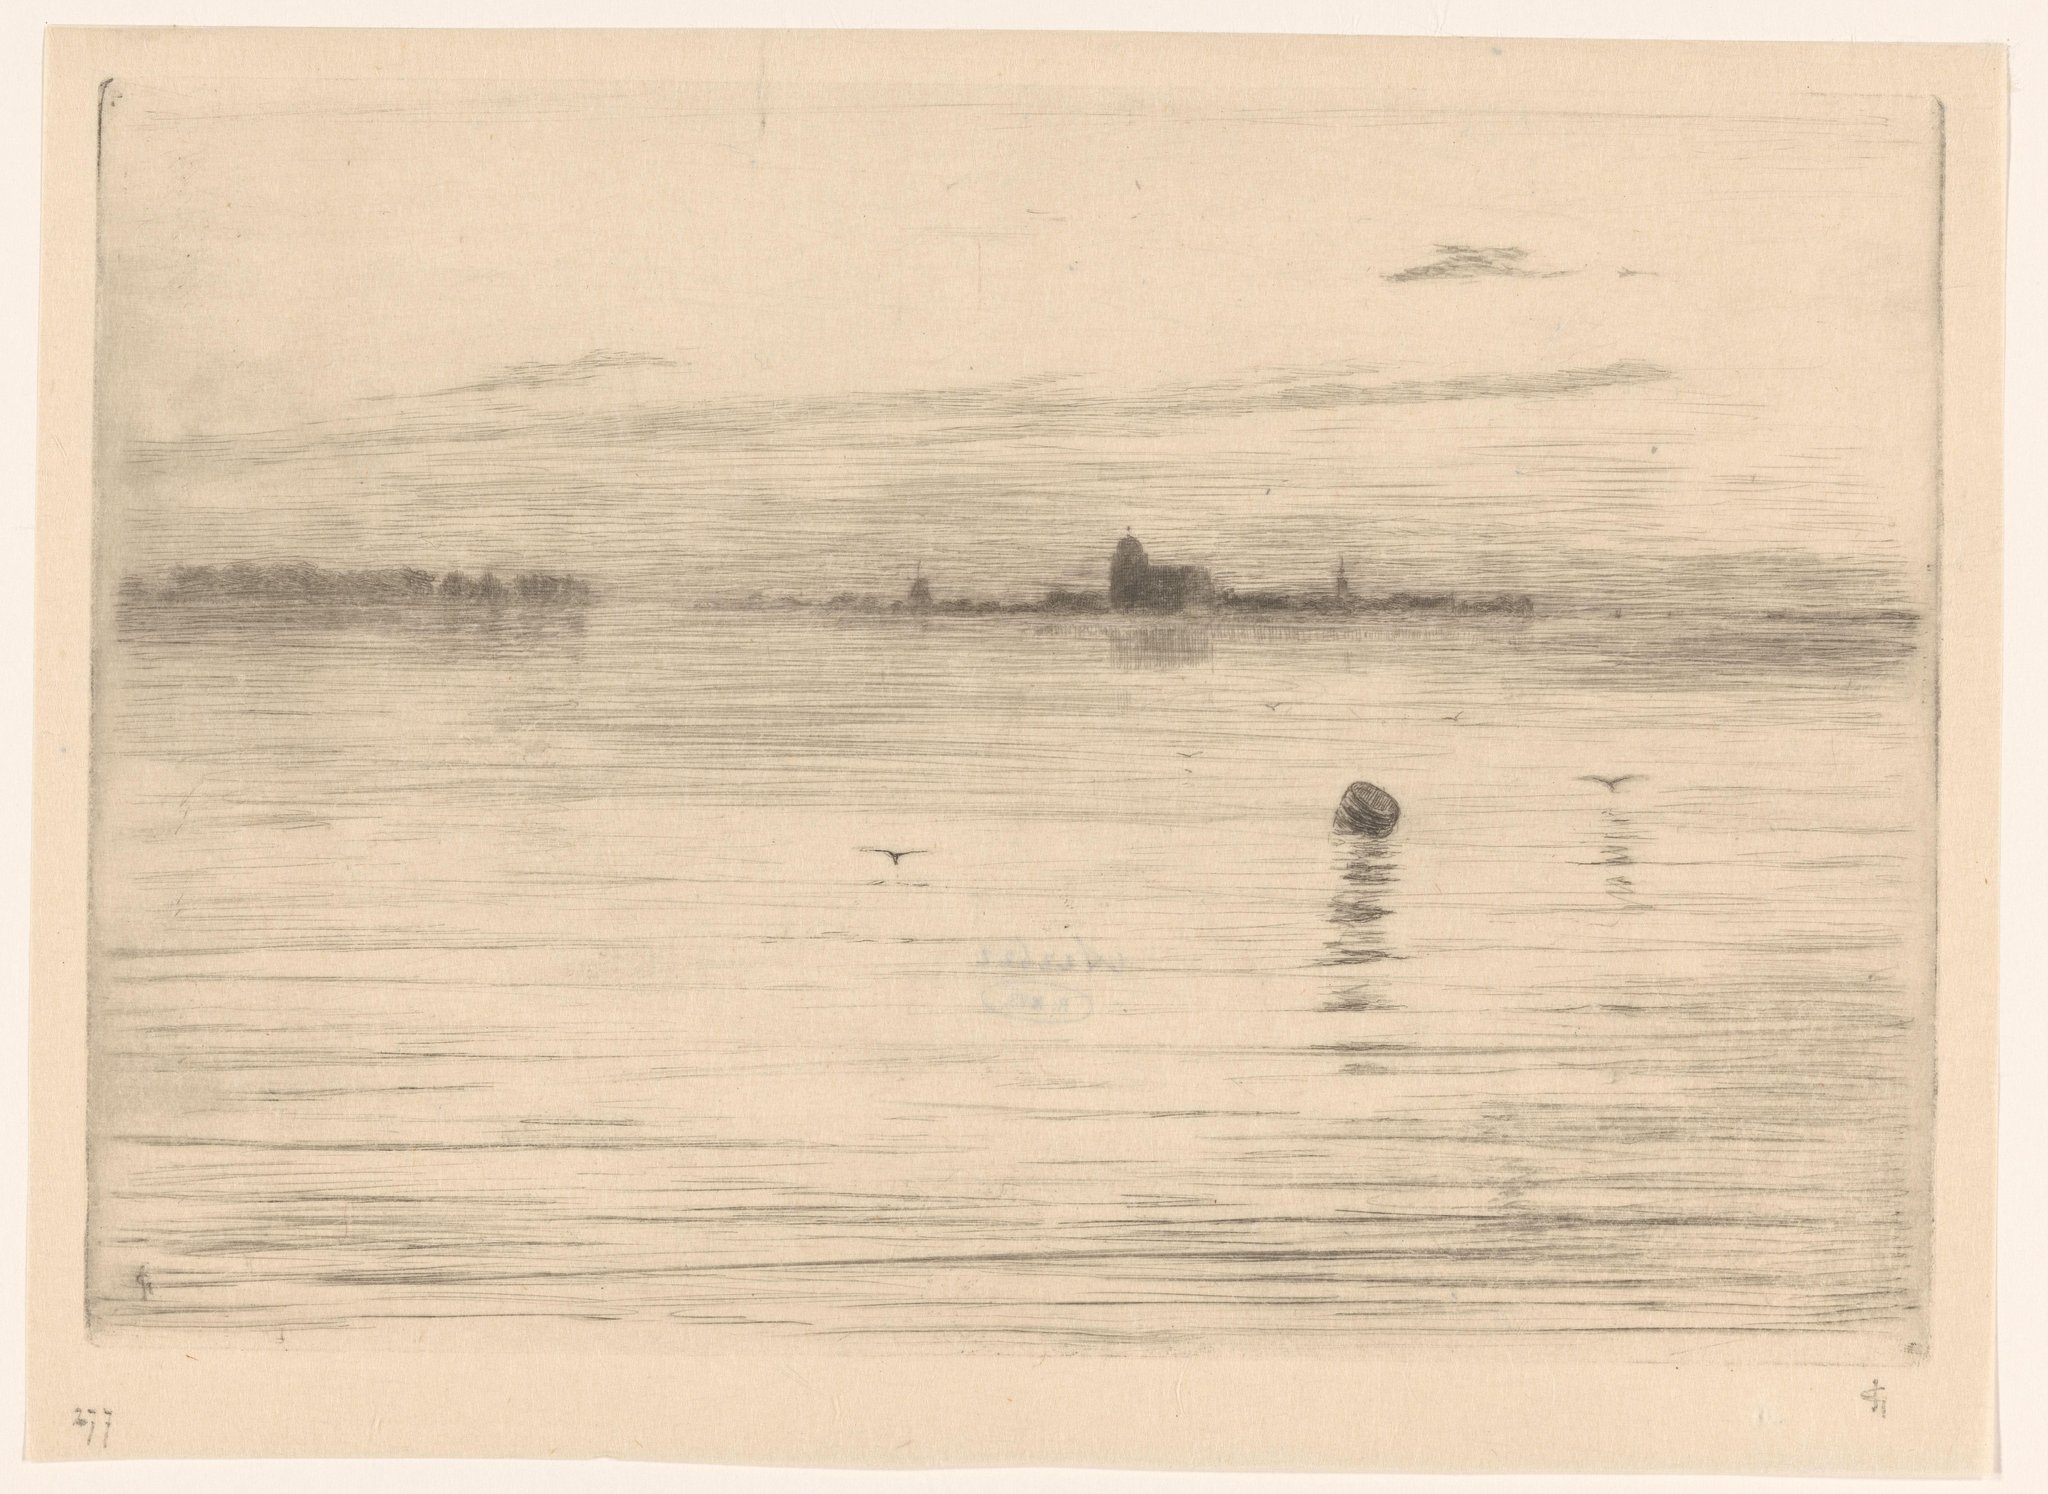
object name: print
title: Gezicht op de Schelde bij Veere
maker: carel nicolaas storm van s-gravesande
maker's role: draughtsman, print maker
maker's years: 1841-1924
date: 1887-1889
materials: paper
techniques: drypoint, etching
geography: netherlands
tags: prospect of village, silhouette of village, river, church (exterior)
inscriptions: collector's mark: Lugt 2228